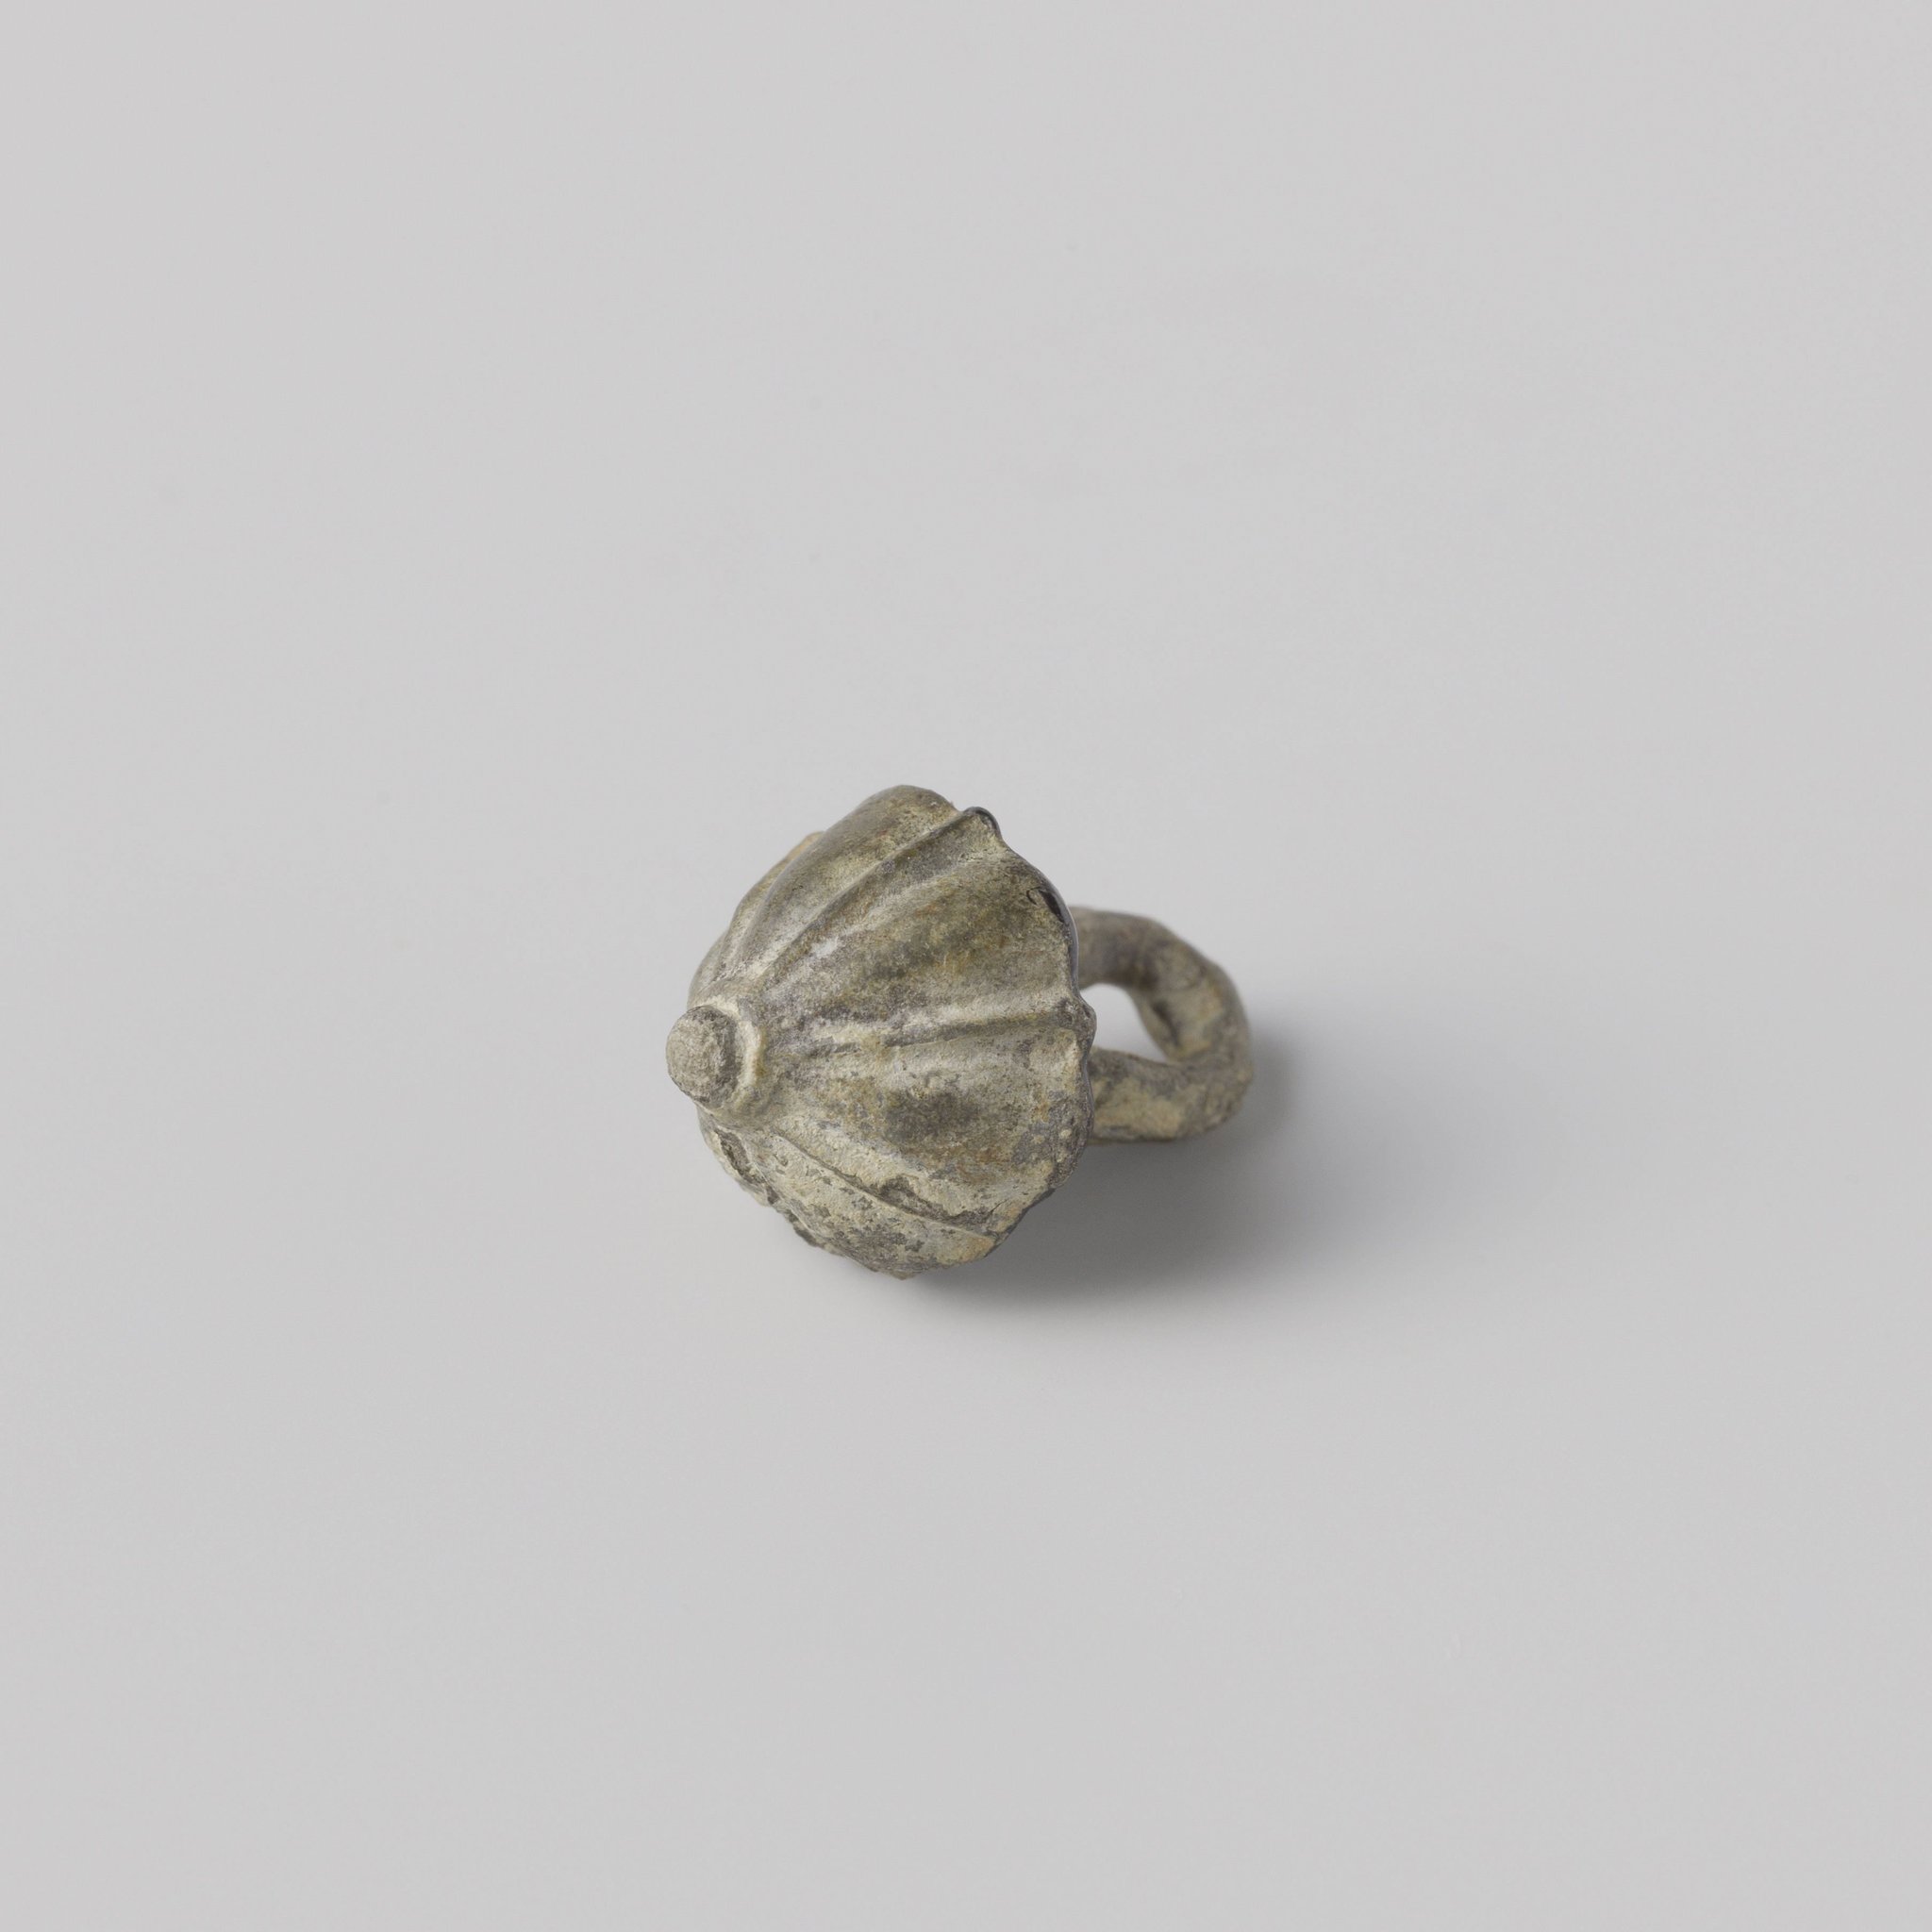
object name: button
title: Knoop, konisch met ribben en bladvormig oog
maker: Anonymous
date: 1590-1596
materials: tin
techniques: casting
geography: amsterdam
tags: willem barendsz., amsterdam, jacob van heemskerck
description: Knoop, konisch van vorm met zes ribben die in een punt samenkomen en een bladvormig oog.